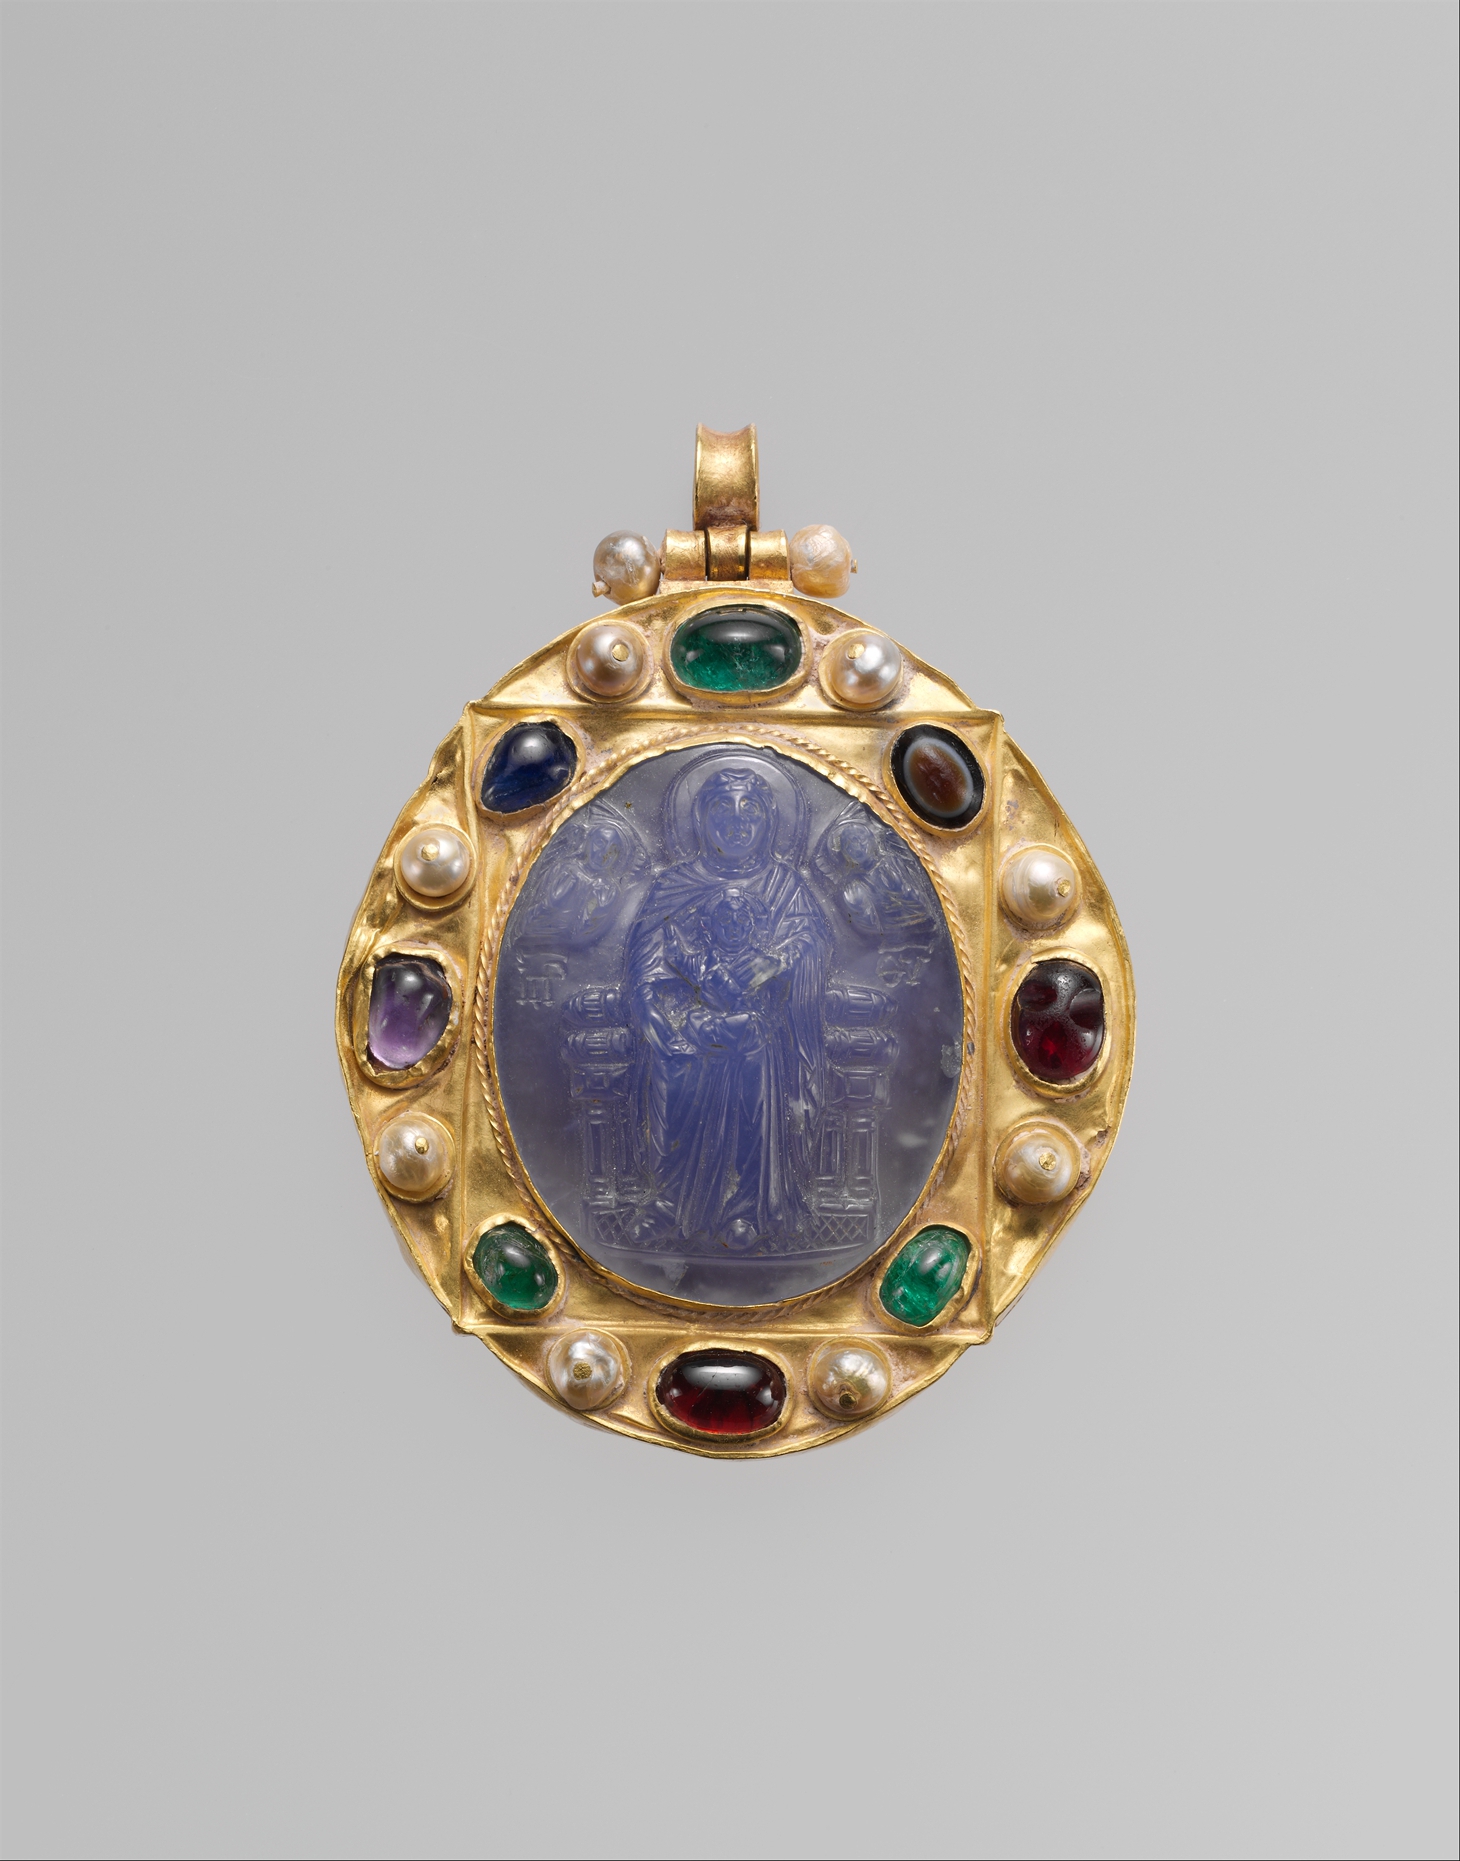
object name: brooch or pendant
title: Pendant Brooch with Cameo of Enthroned Virgin and Child and Christ Pantokrator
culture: byzantine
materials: stone, gemstone, garnet, gold, pearl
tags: angels,christ,madonna and child